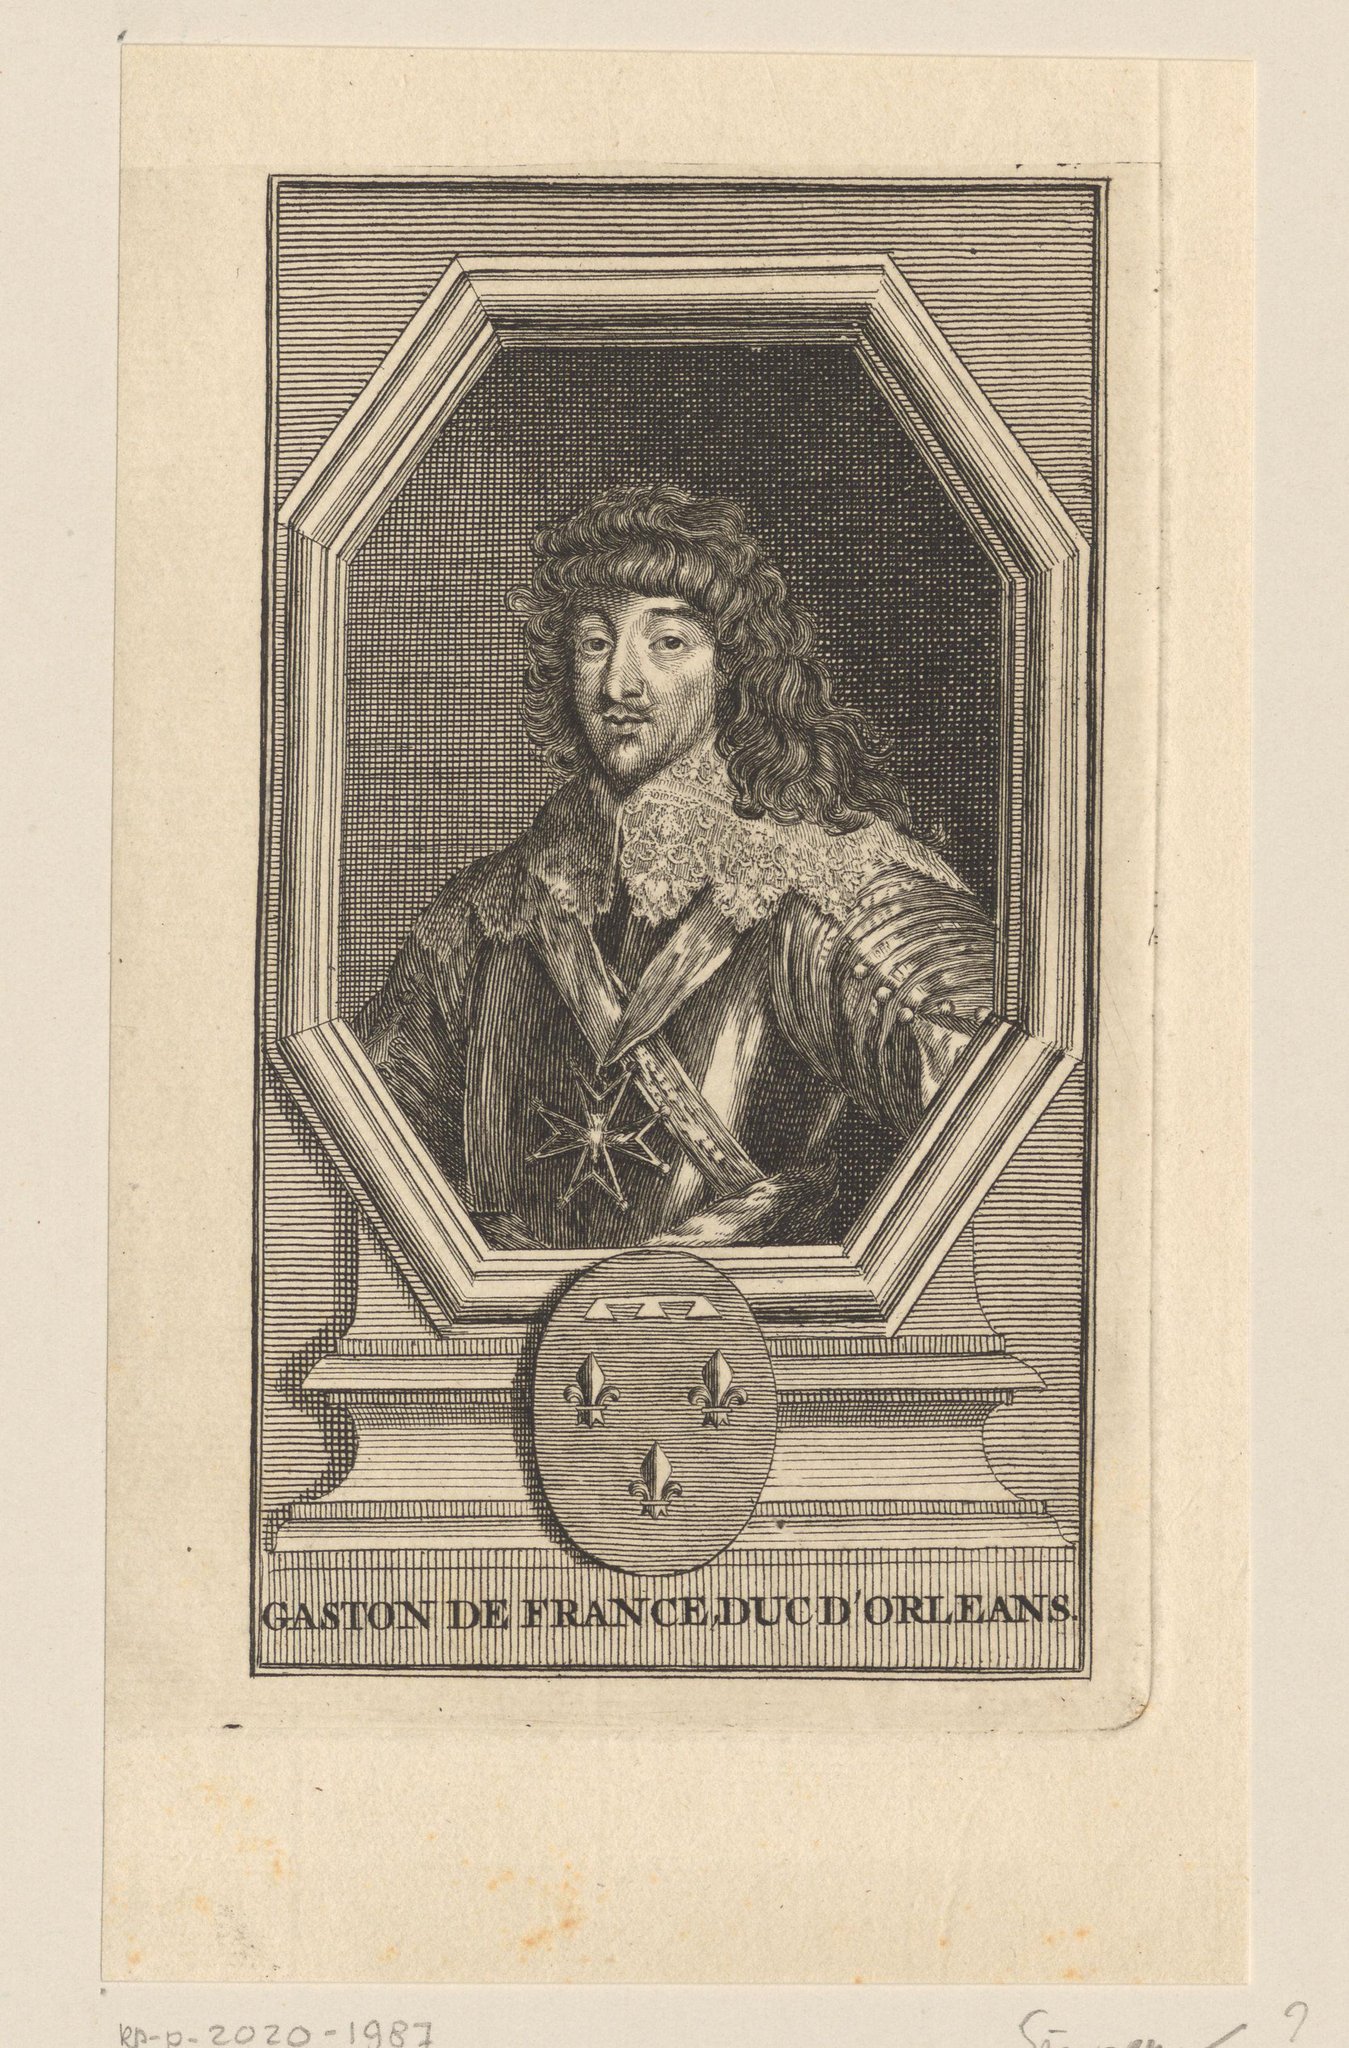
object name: print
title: Portret van Gaston Jean-Baptiste Orléans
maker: Anonymous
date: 1654-1660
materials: paper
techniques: engraving, etching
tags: gaston jean-baptiste hertog van orléans, historical persons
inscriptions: collector's mark: Lugt 2228